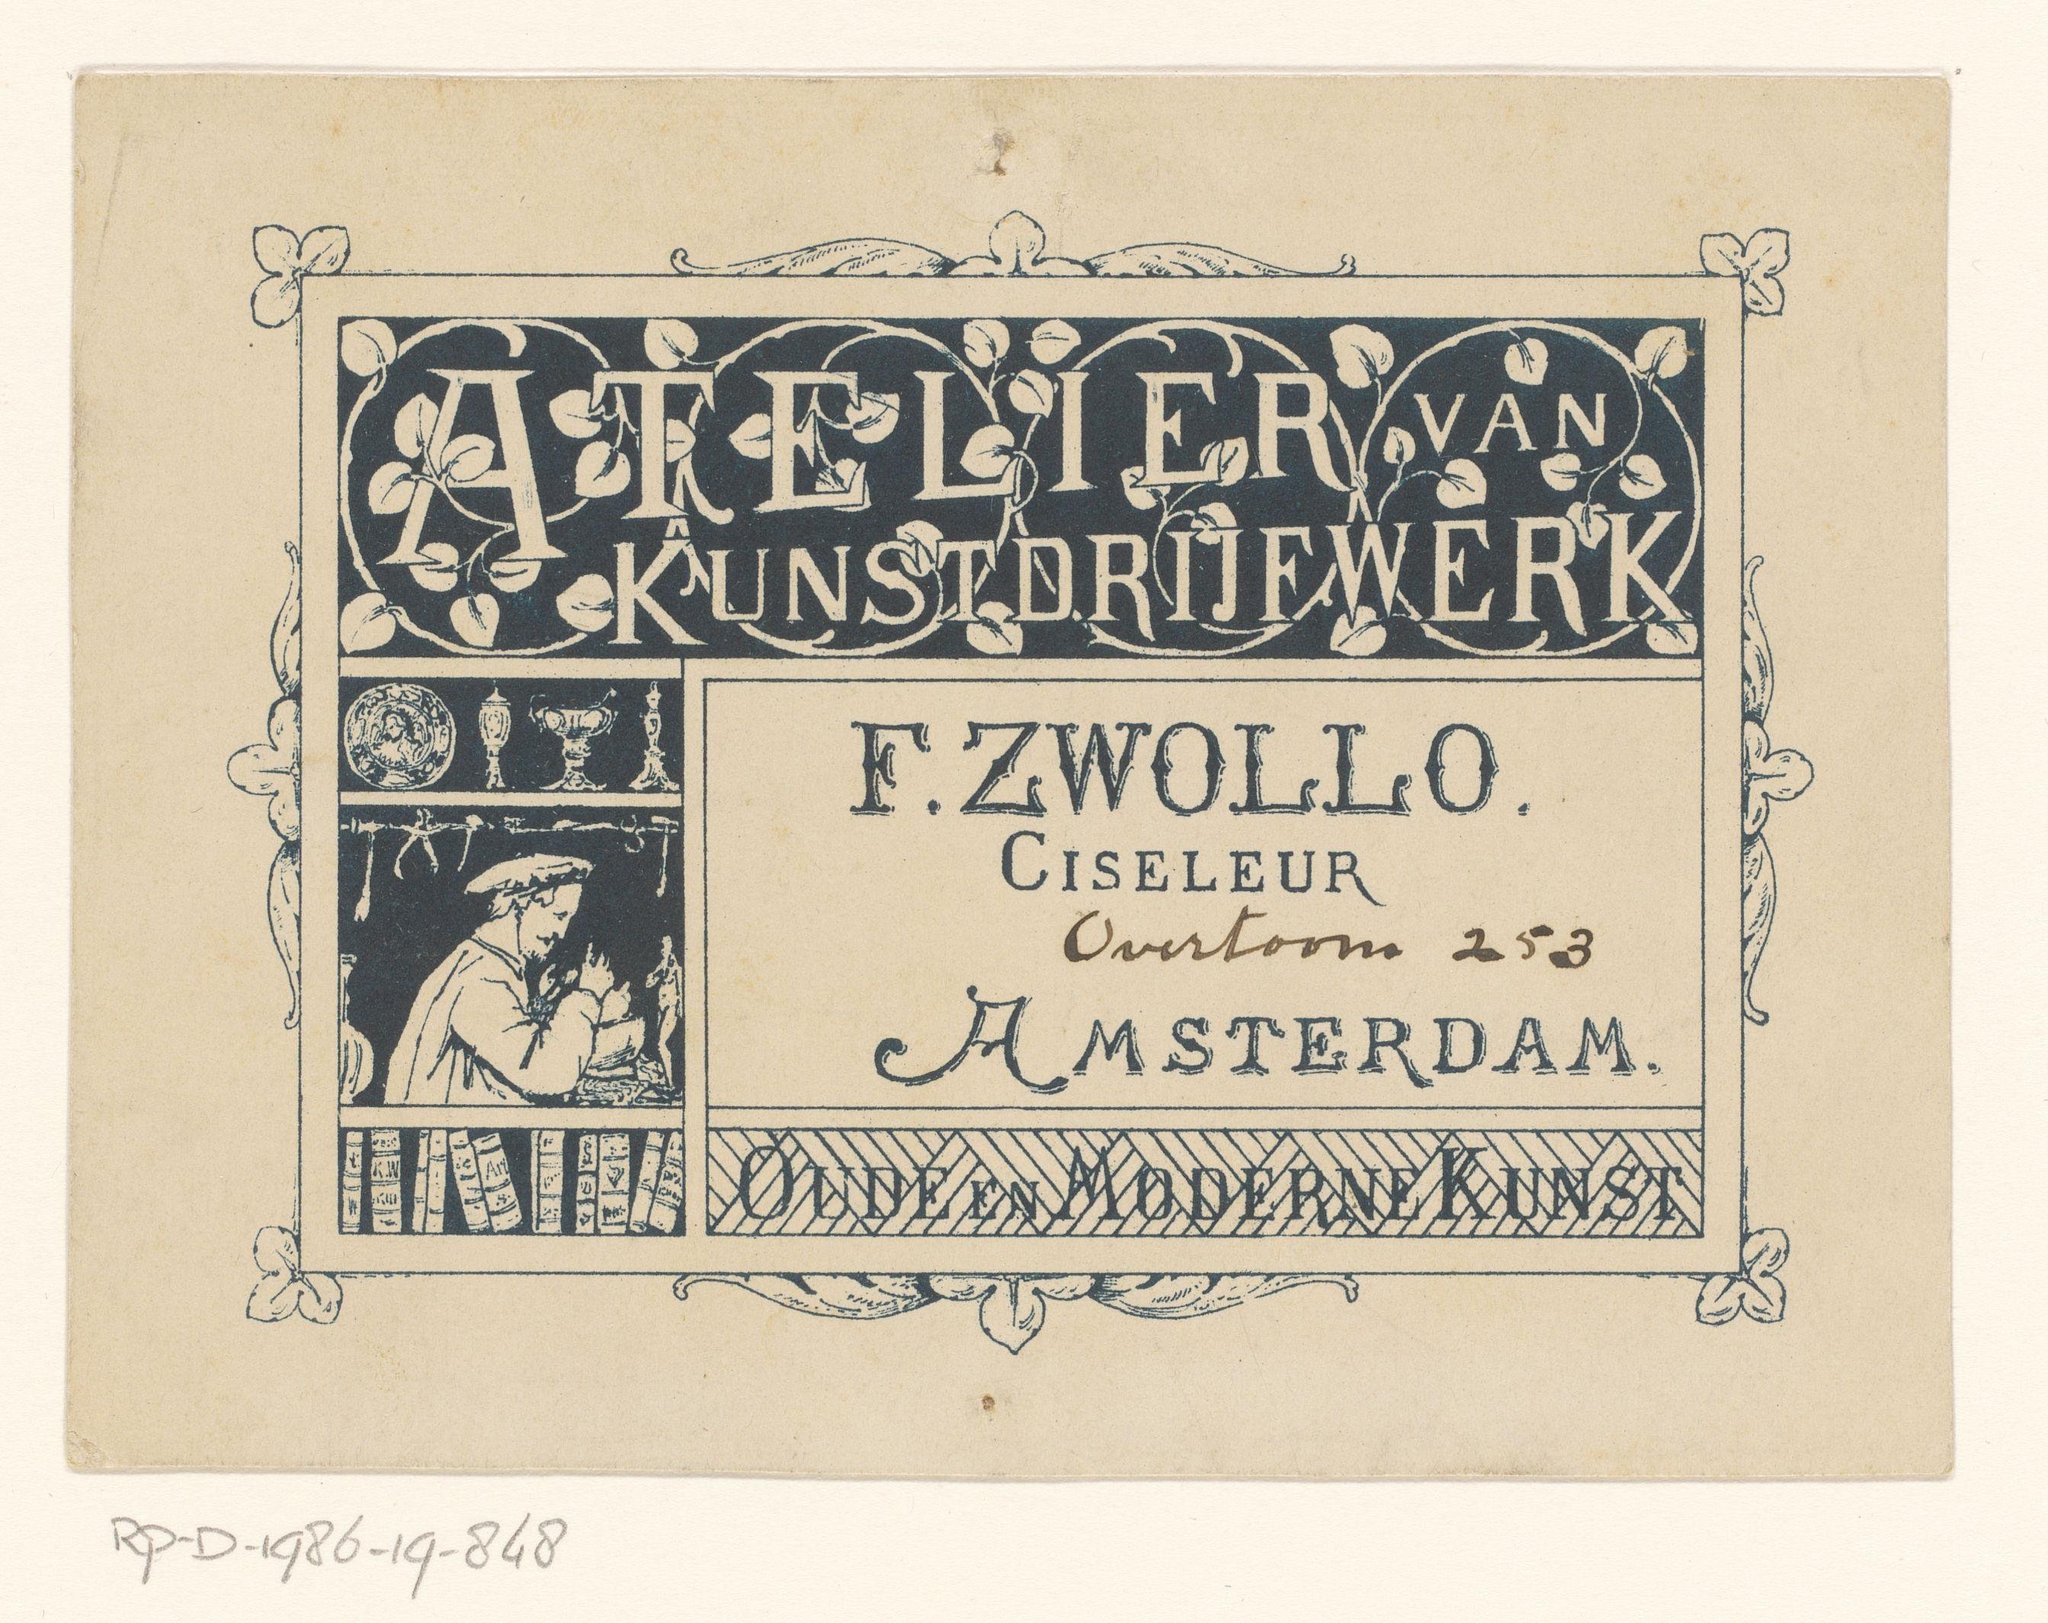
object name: business card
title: Adreskaart van Atelier van Kunstdrijfwerk F. Zwollo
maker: Anonymous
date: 1900-1910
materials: paper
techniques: lithograph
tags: silversmith, frans zwollo (i), foliage, tendrils, branches ~ ornament, craftsman ~ applied arts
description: Decoratief kader met bladmotief en linksonder een ciseleur aan het werk. Het adres is met de hand op de kaart genoteerd.